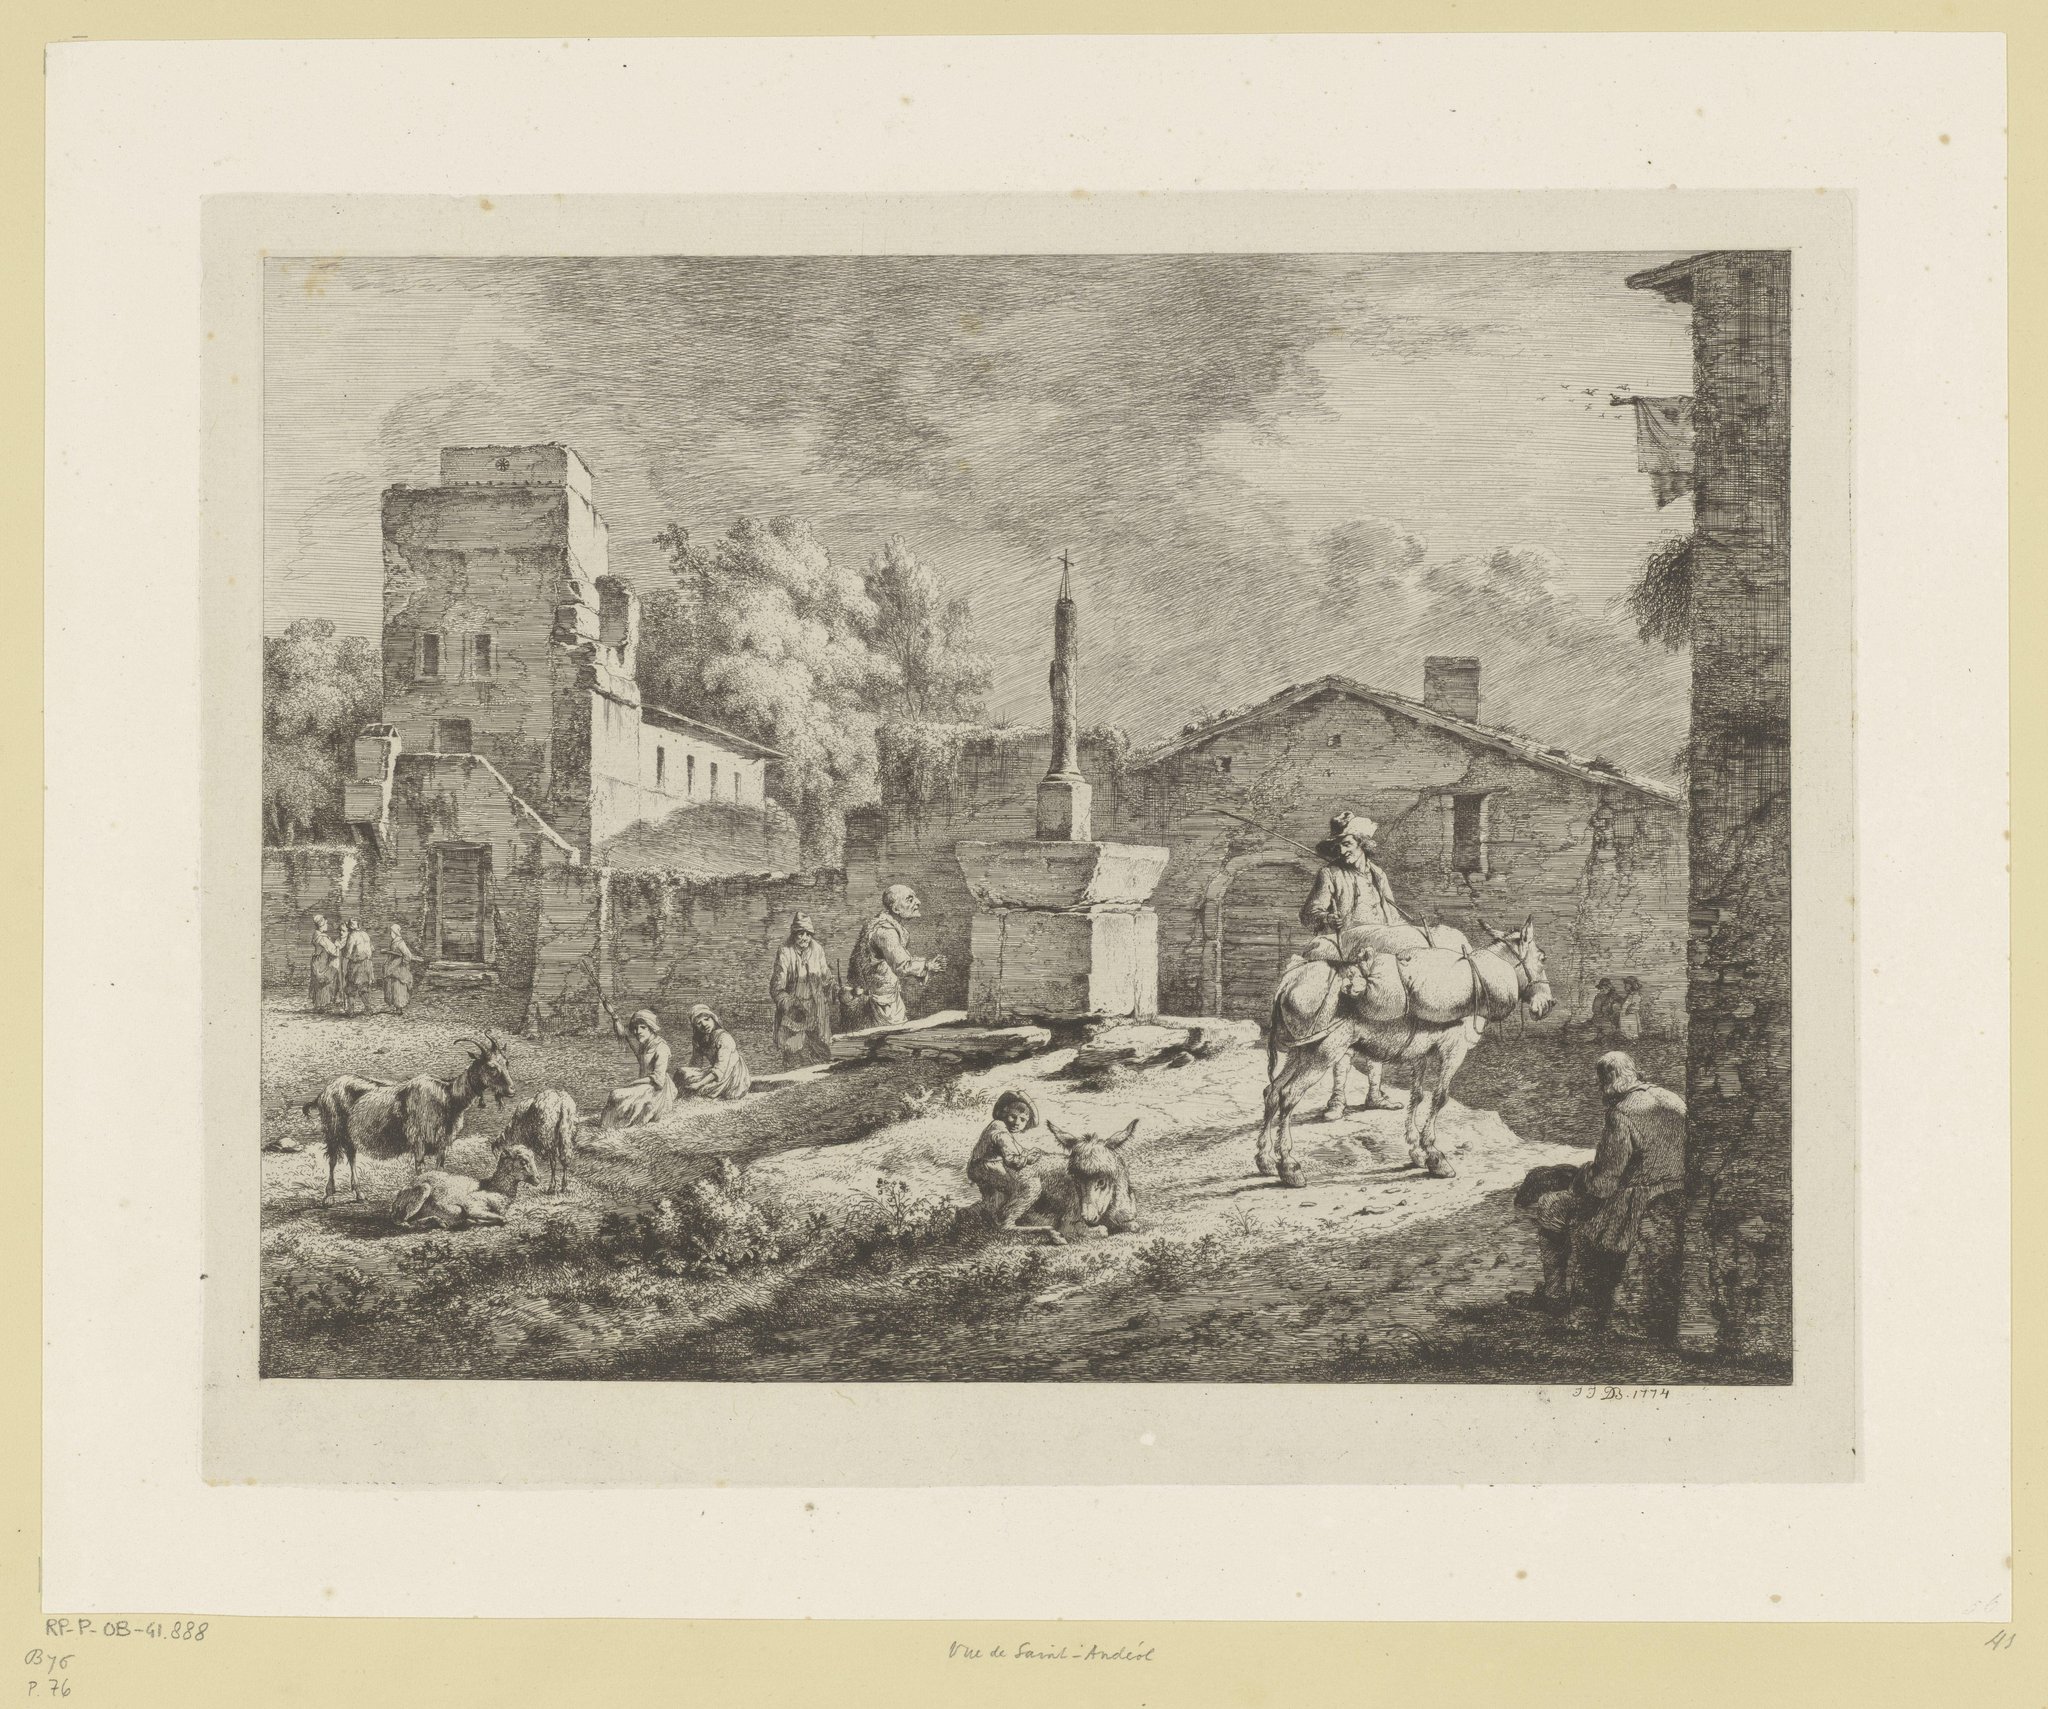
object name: print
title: Gezicht op het dorpsplein van Bourg-Saint-Andéol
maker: jean jacques de boissieu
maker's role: draughtsman, print maker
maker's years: 1736-1810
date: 1774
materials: paper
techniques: drypoint, etching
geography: france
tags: city-view in general; 'veduta', ass, donkey, village square, place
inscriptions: collector's mark: Lugt 12